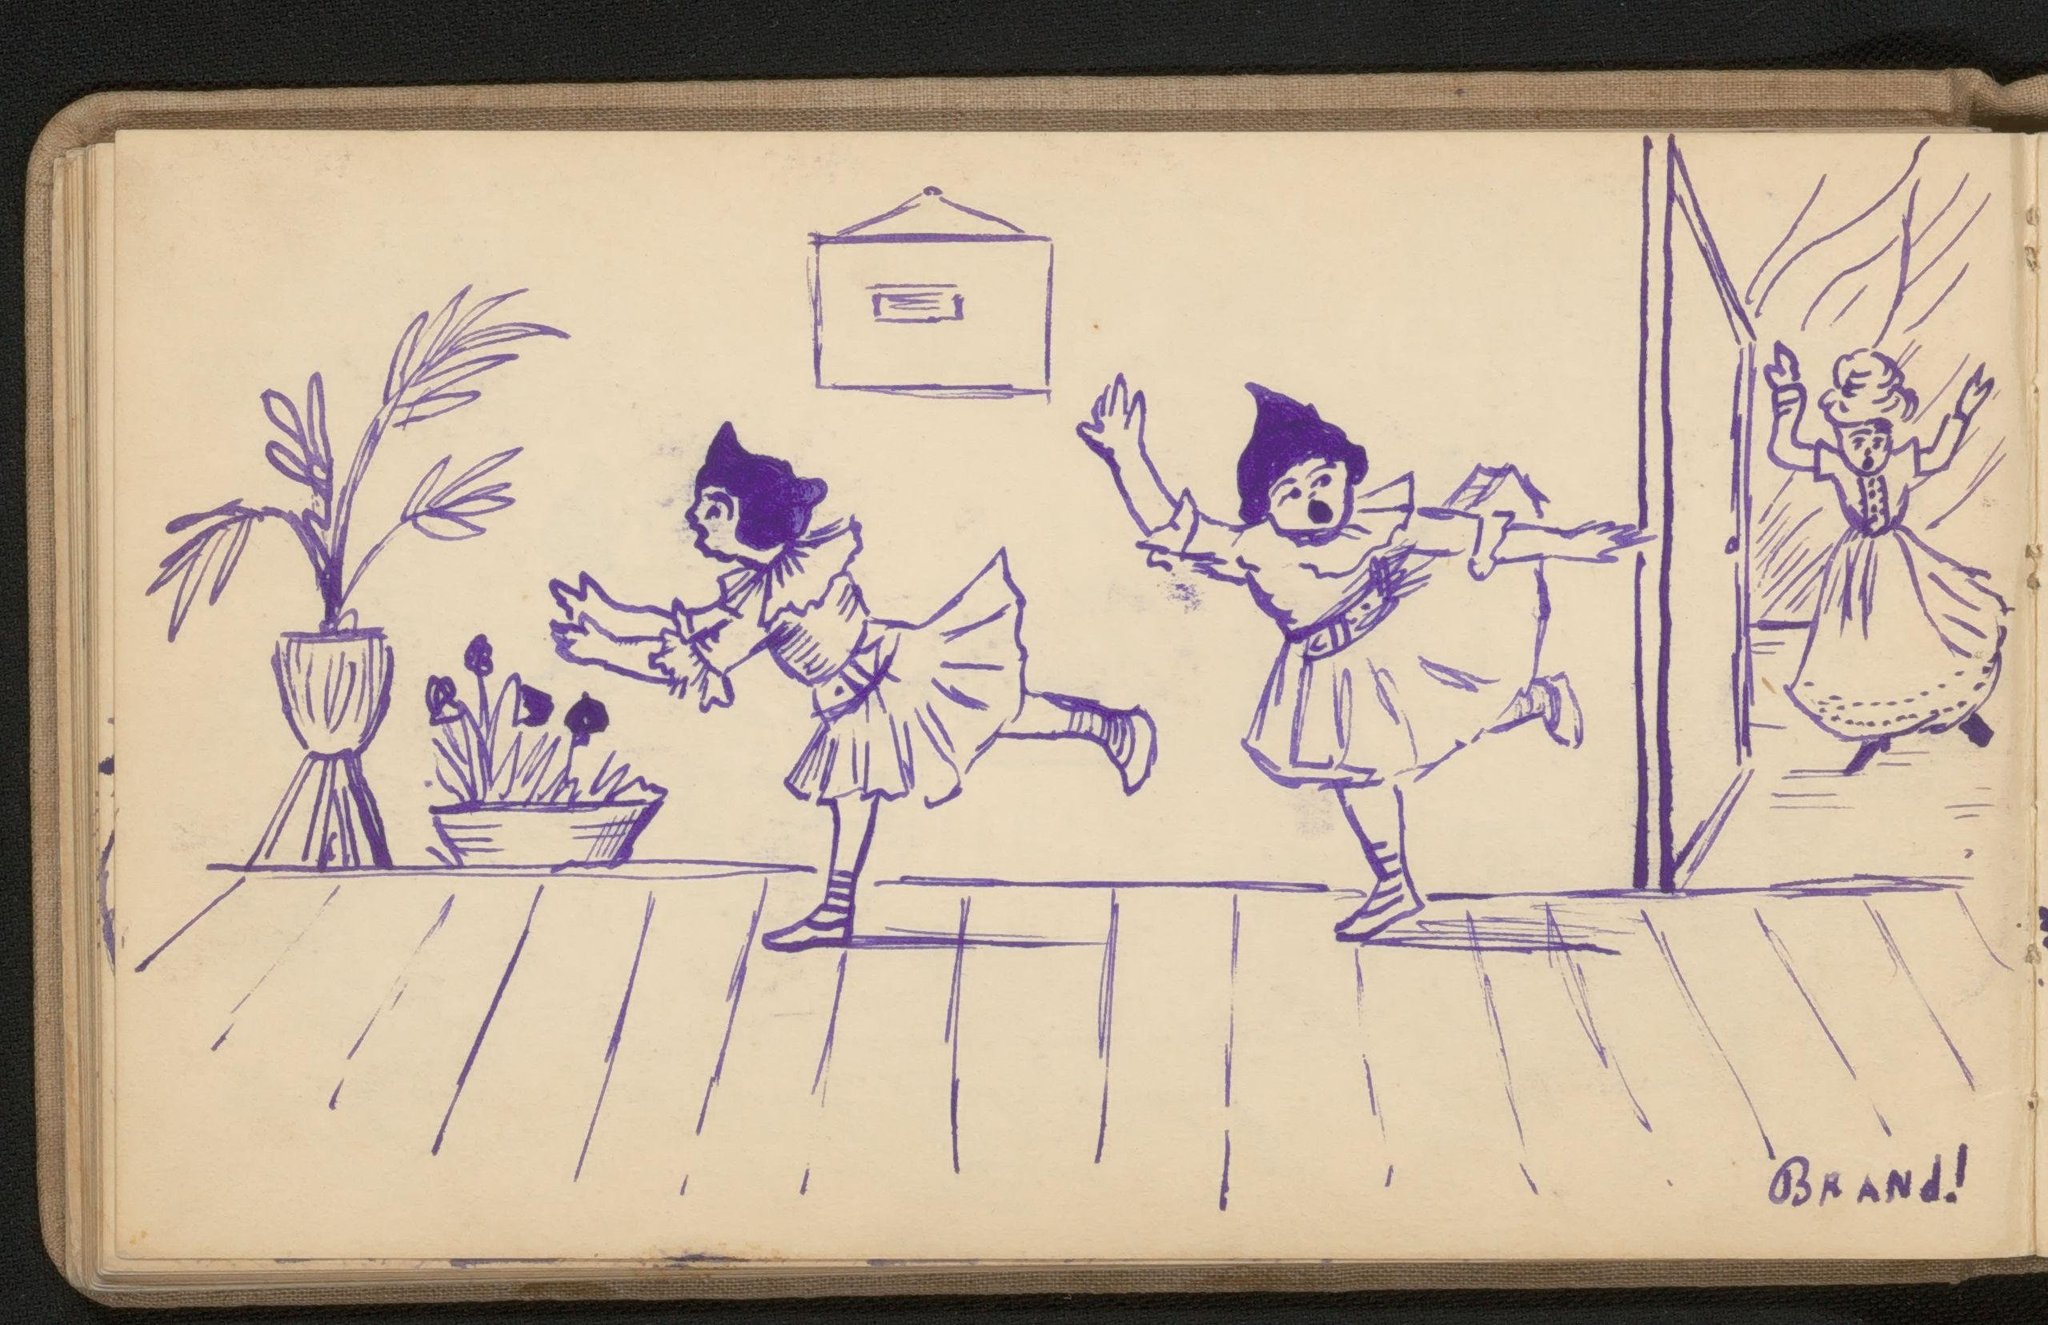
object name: sketchbook leaf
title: Brand!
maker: Anonymous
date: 1875-1920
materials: ink, paper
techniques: pen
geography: netherlands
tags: on fire, ablaze, family life at home, living-room, parlour, sitting-room, breaking something (household accident)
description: Brand in de huiskamer na met omvallen van de lamp. Onderdeel van het schetsboek met humoristische tekeningen over het leven van een 'famille nombreuse'. Onderwerpsrubrieken binnen de Atlas Zeden en Gewoonten: Zeden en Gewoonten in Engeren Zin, Des menschen beging, midden en einde, Kinderleven.